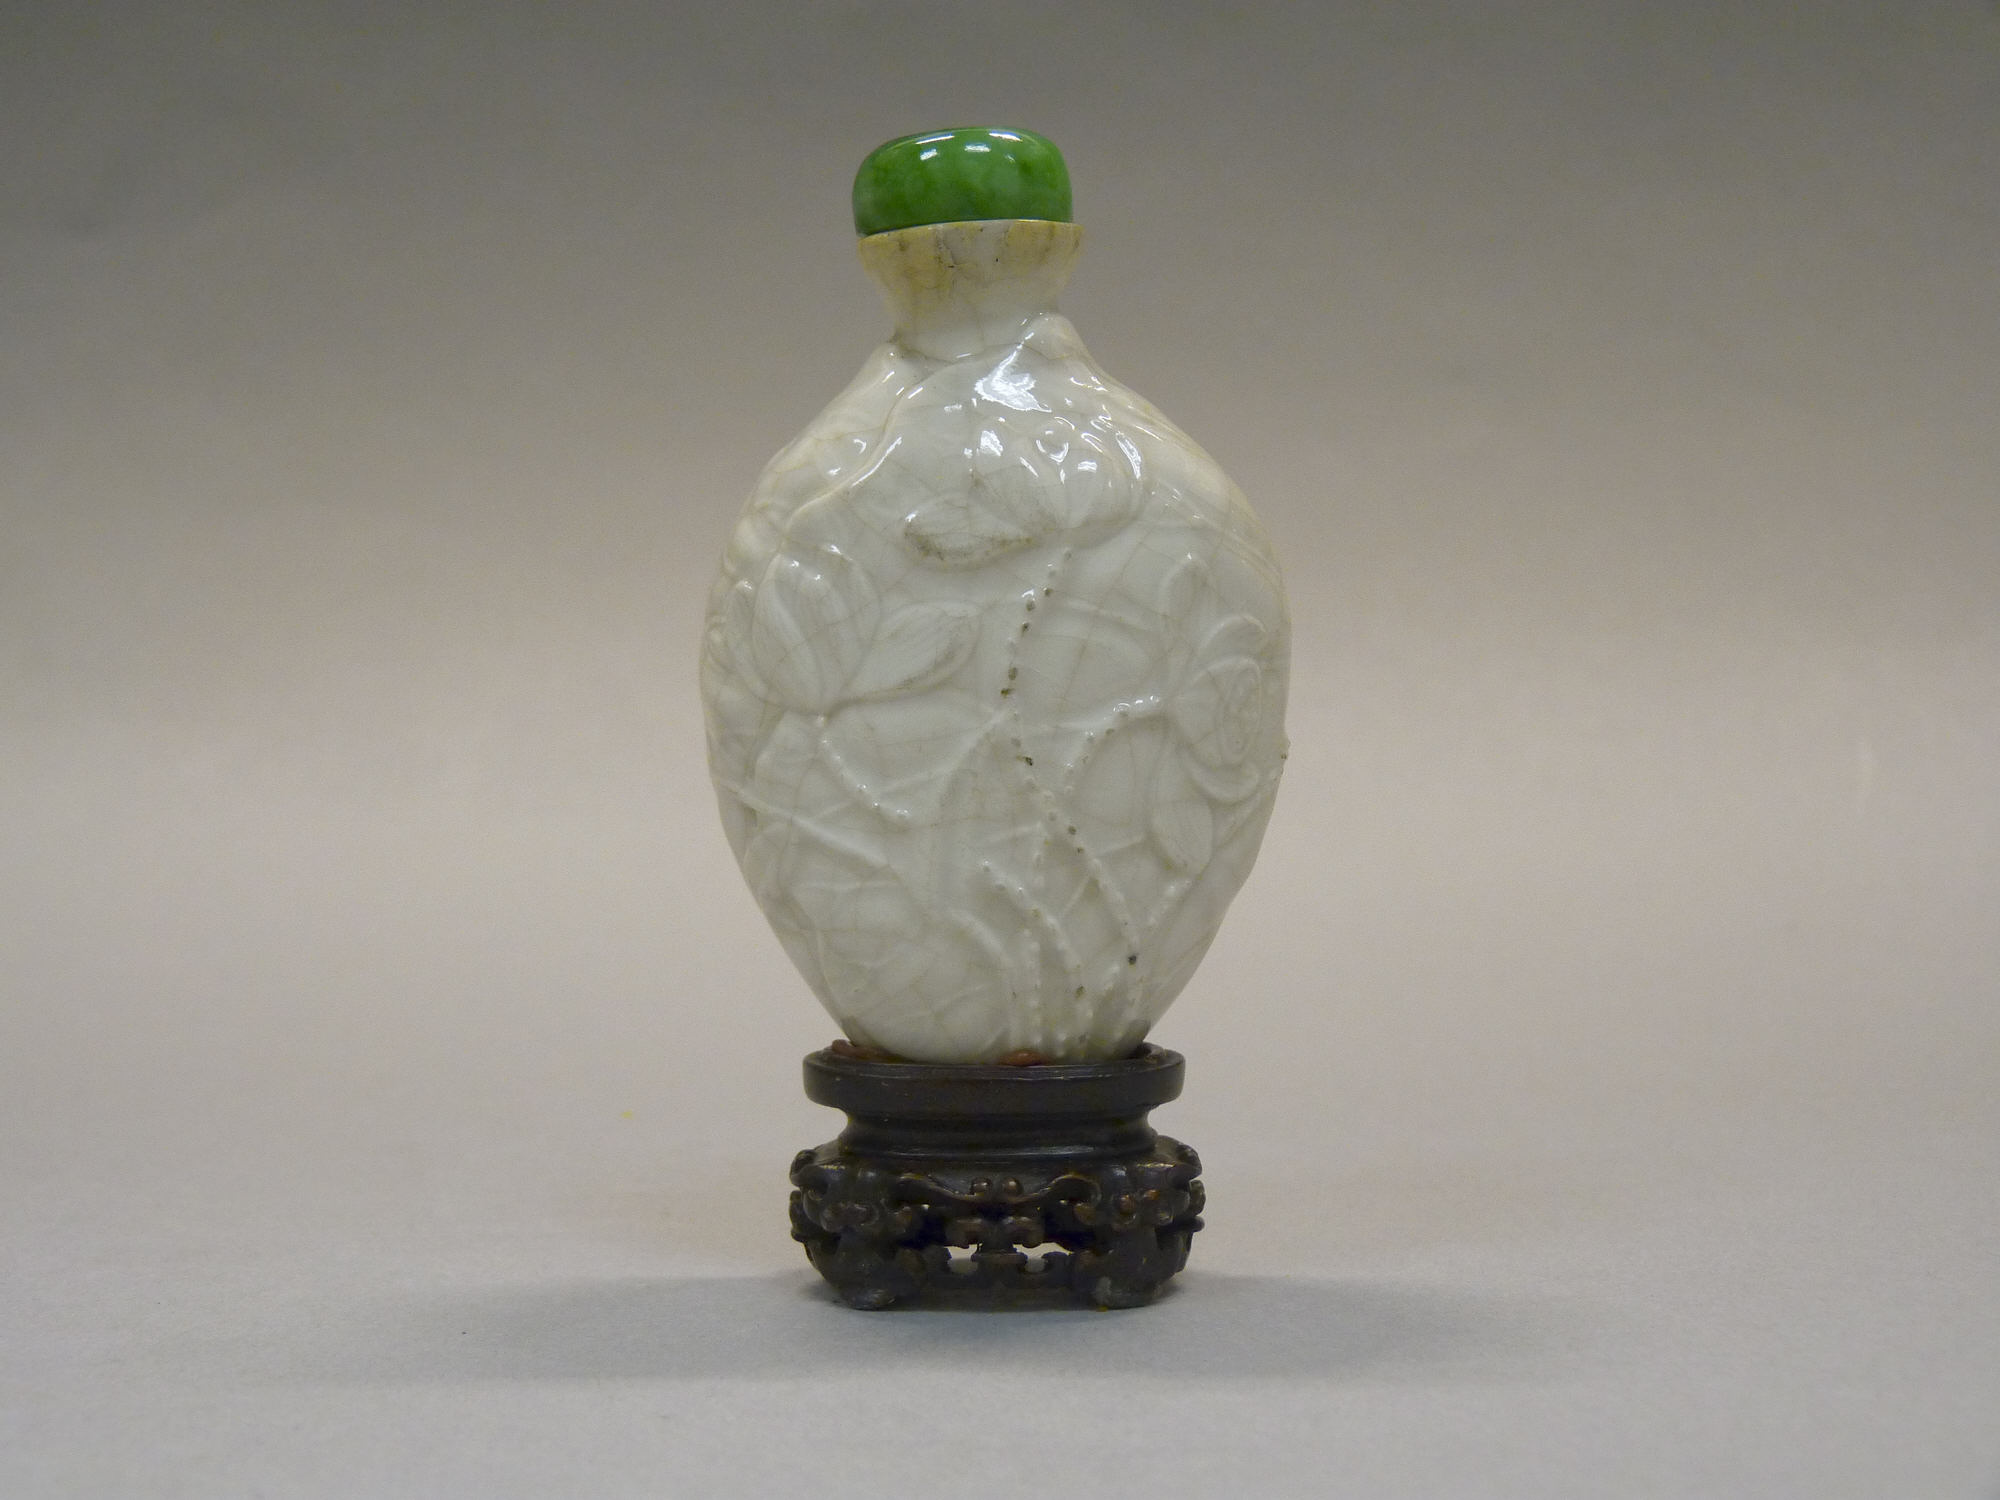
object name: snuff bottle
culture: chinese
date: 1736-1795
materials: jade, soft paste porcelain